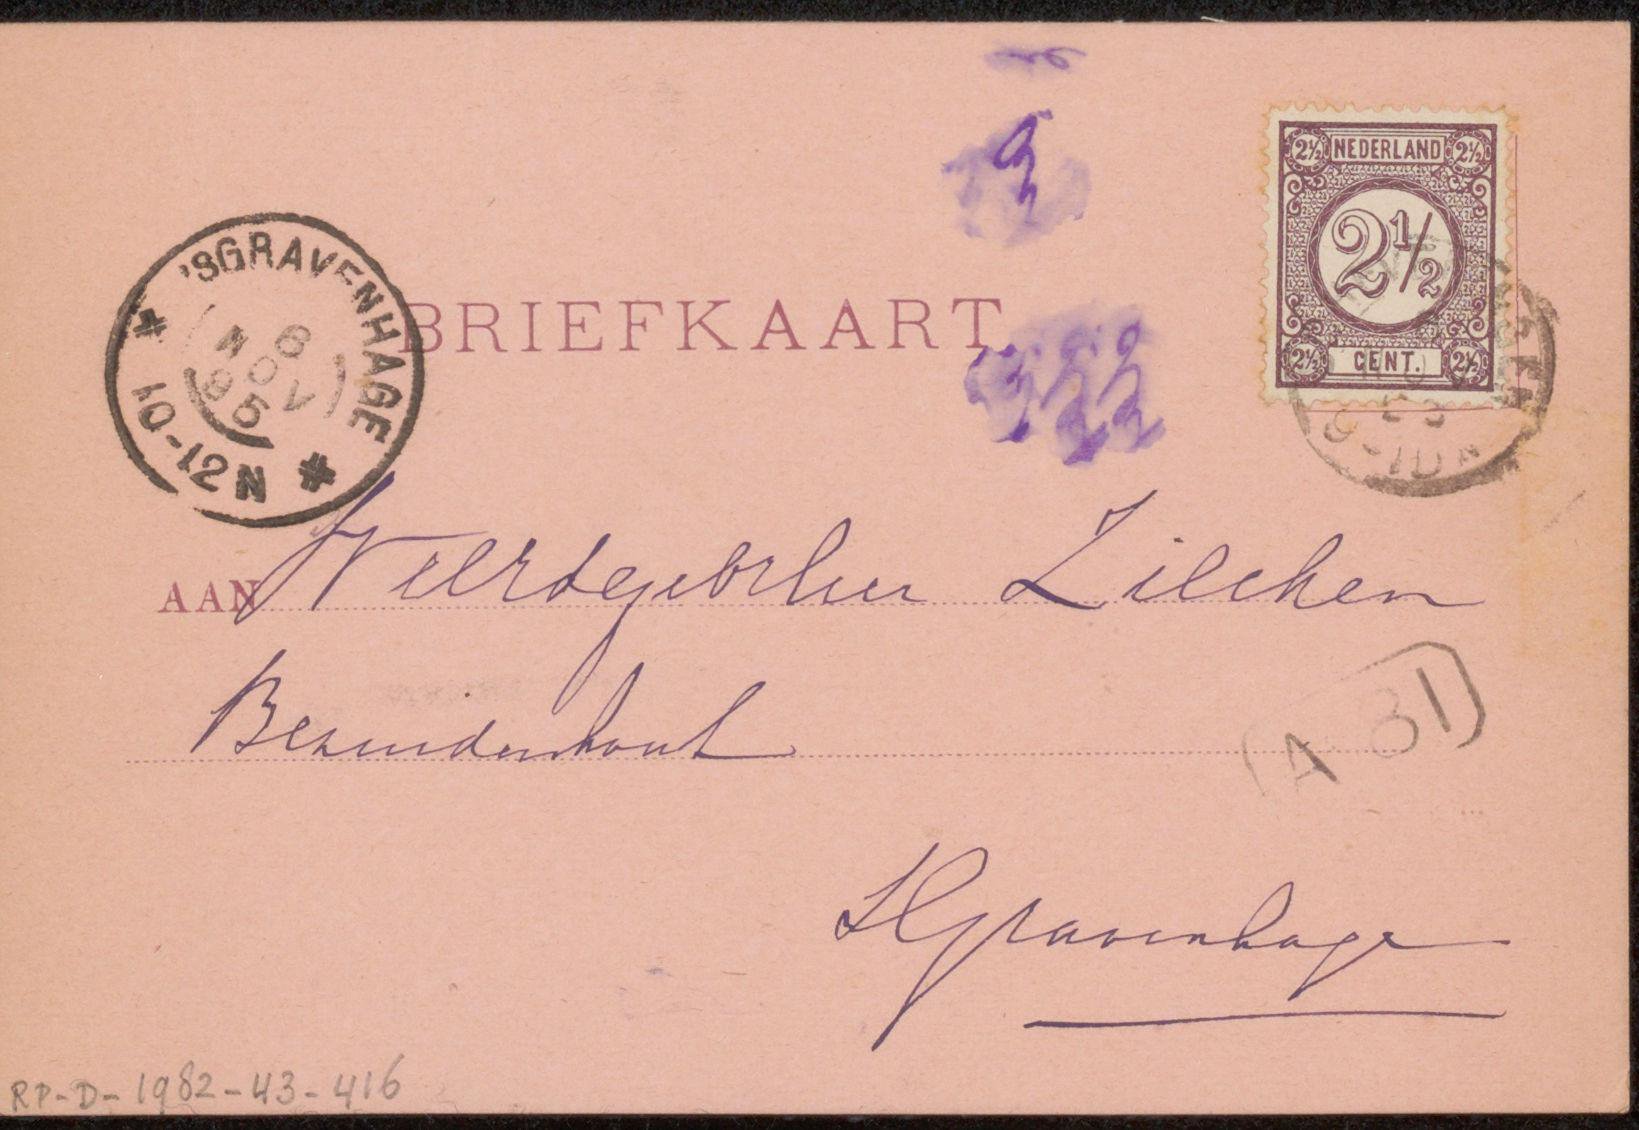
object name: postcard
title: Briefkaart aan Philip Zilcken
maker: theo van hoytema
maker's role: draughtsman, painter, print maker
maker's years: 1863-1917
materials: cardboard, ink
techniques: pen, writing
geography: the hague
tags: helène lambertine hauzeur, philip zilcken, passions, emotions, affections